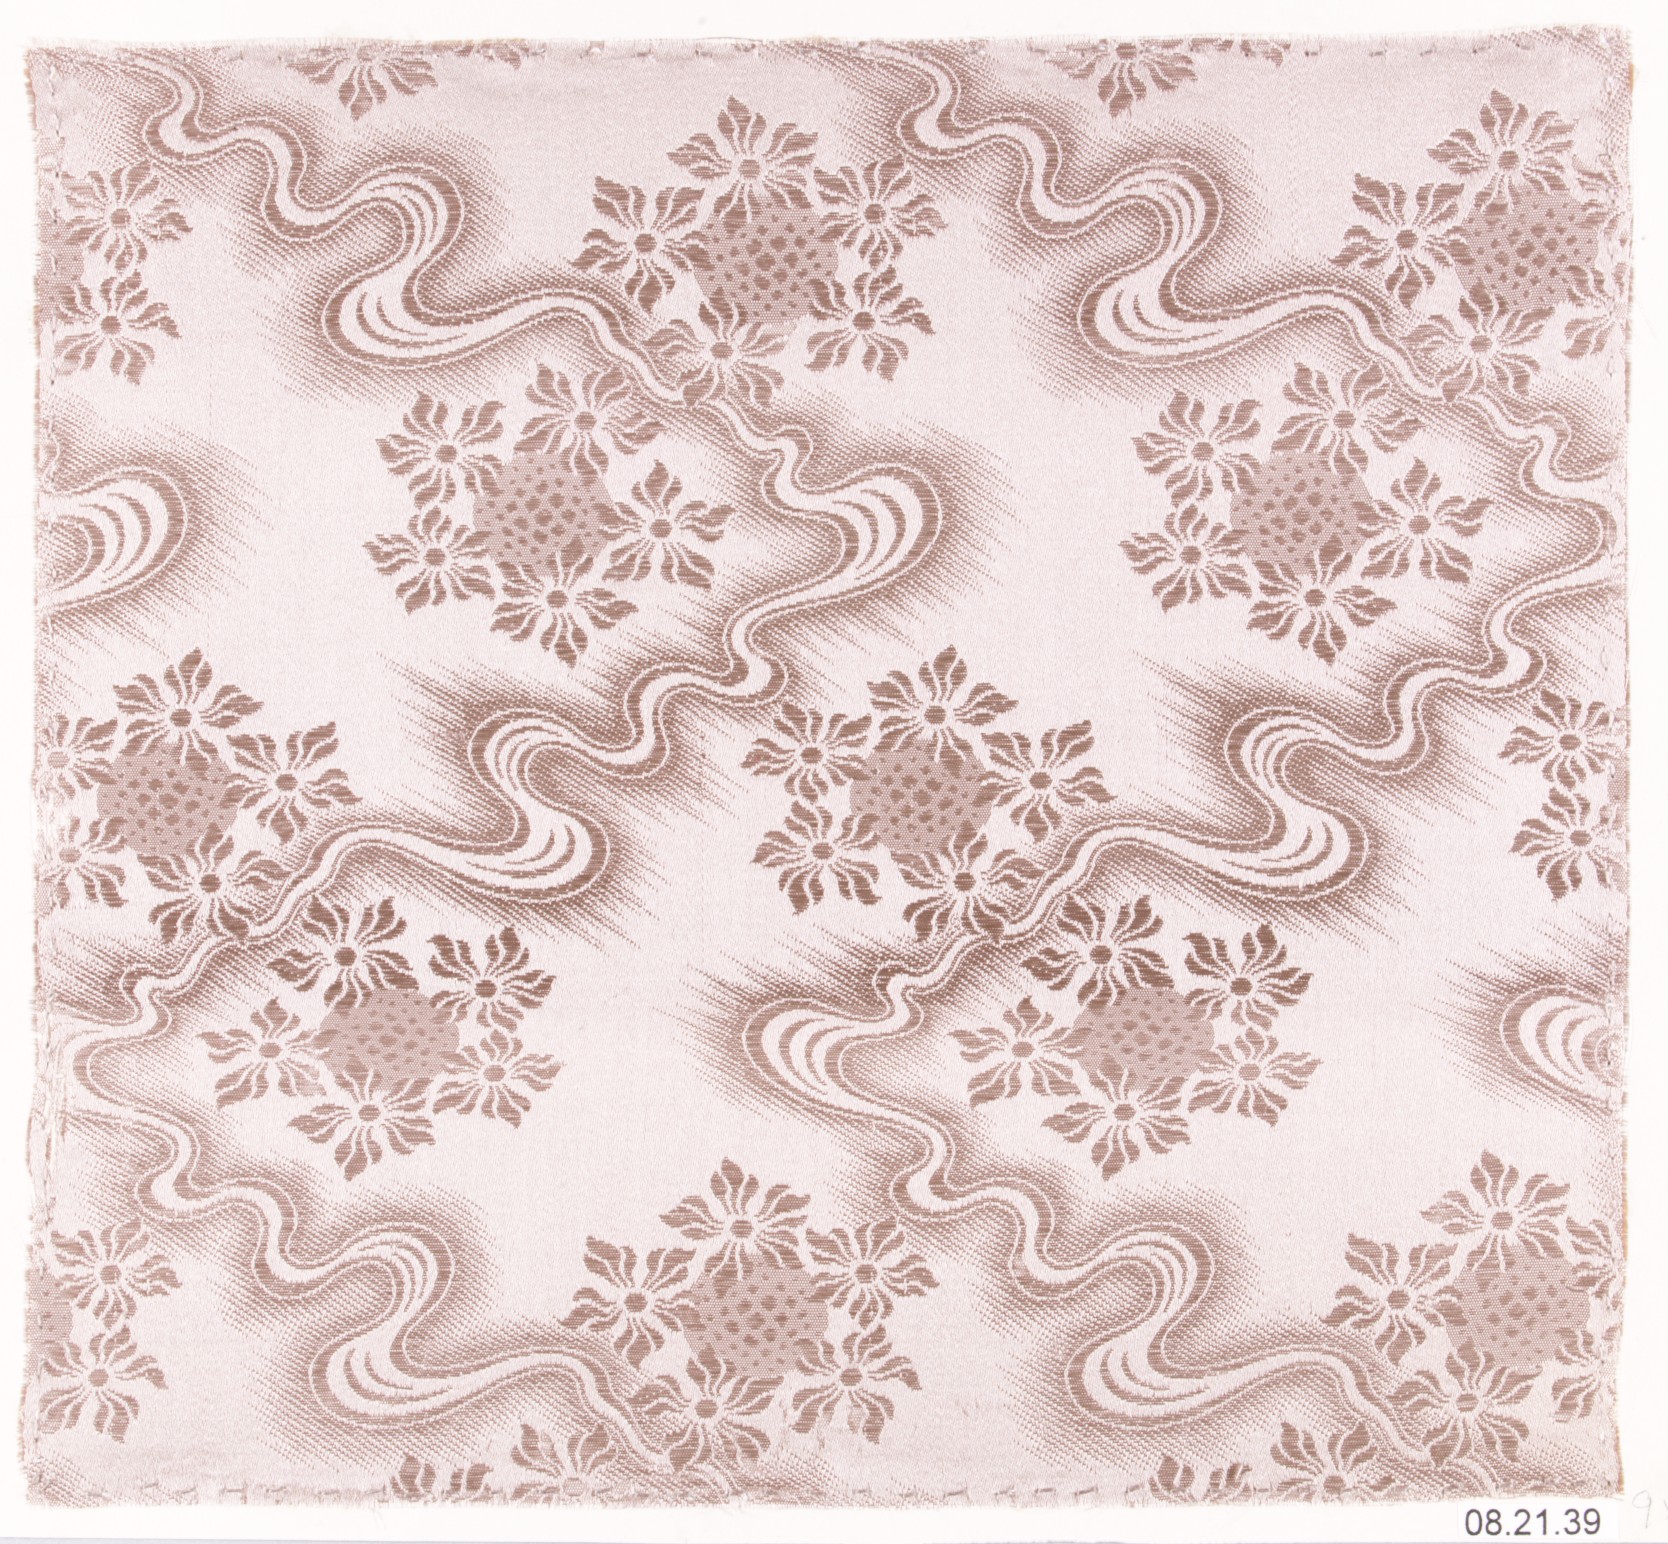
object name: textile sample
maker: Anonymous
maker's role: designer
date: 1900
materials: silk